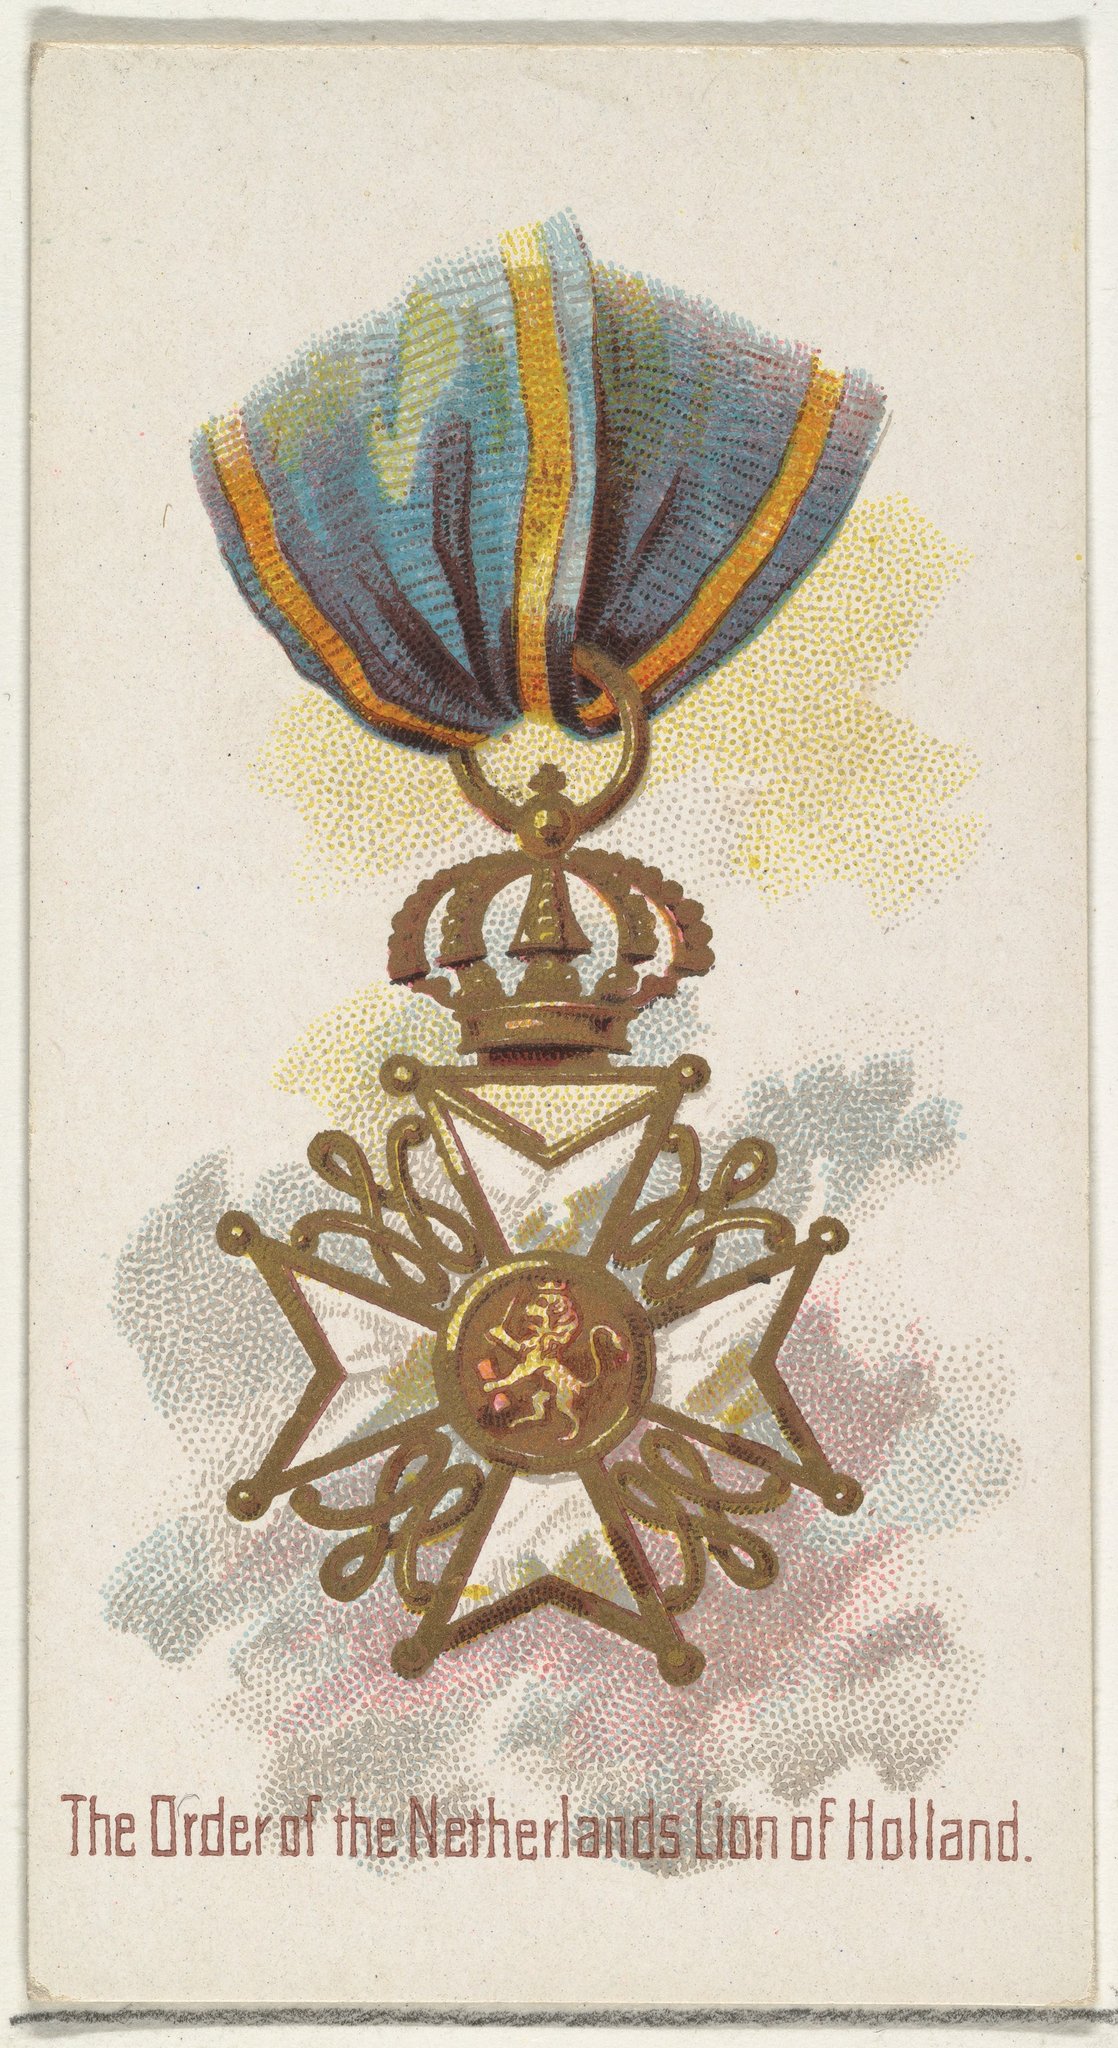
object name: print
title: The Order of the Netherlands Lion of Holland, from the World's Decorations series (N30) for Allen & Ginter Cigarettes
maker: allen & ginter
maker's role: publisher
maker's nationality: american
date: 1890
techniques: color lithograph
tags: medals